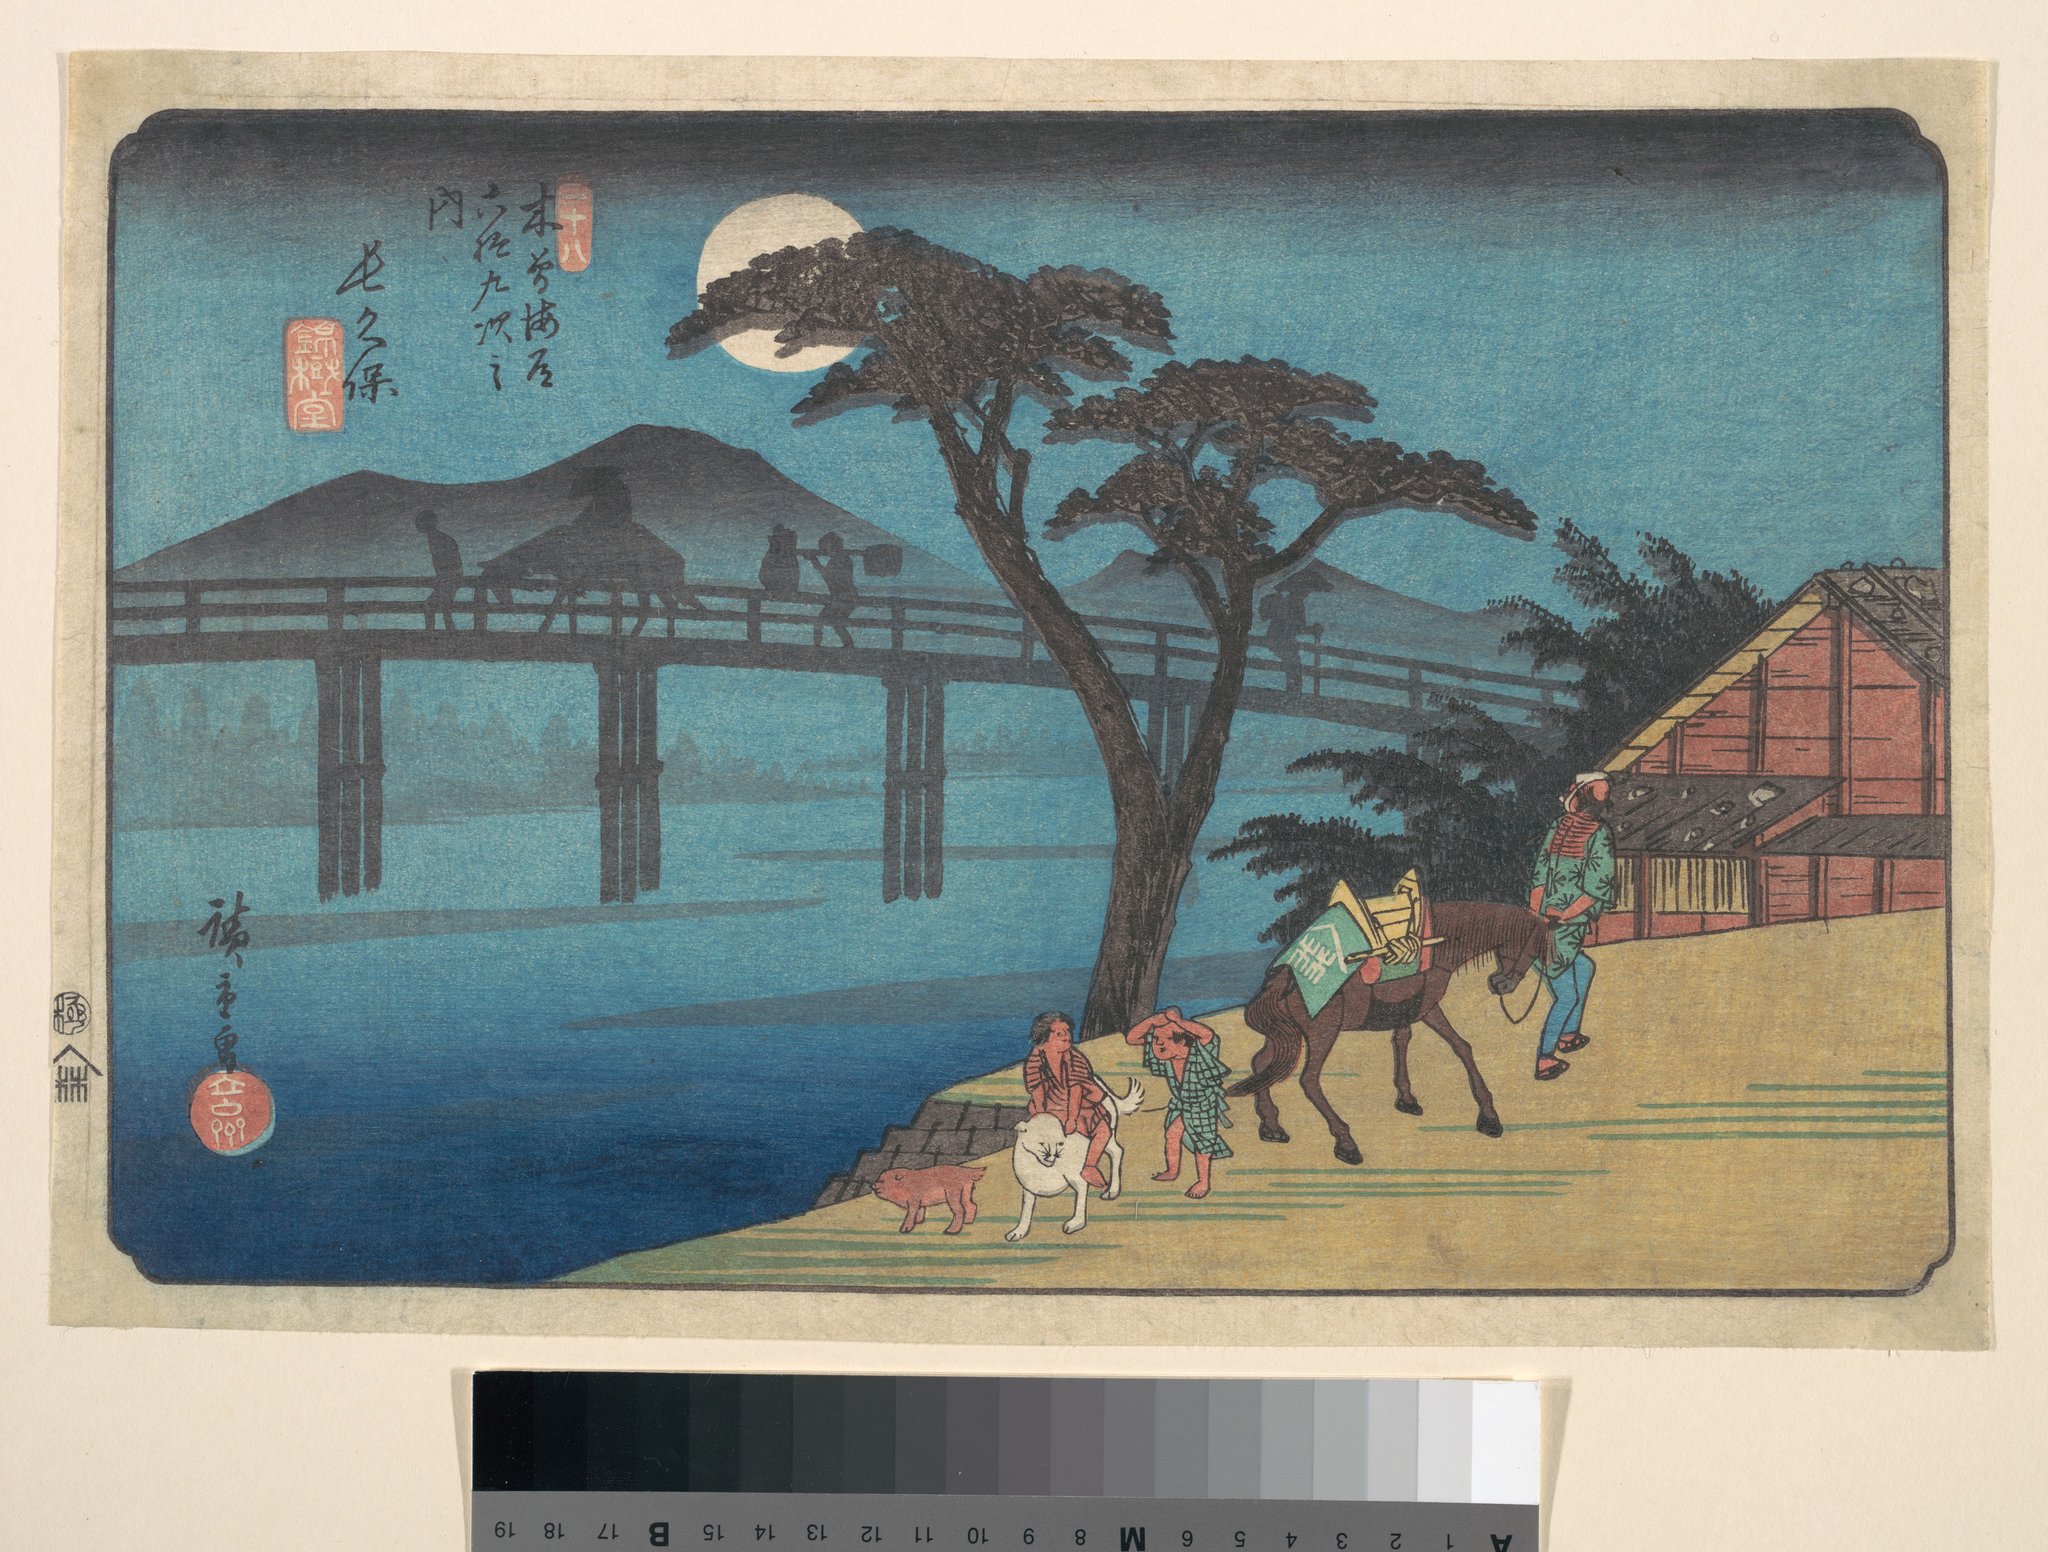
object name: print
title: Nagakubo Station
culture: japanese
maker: utagawa hiroshige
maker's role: artist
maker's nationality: japanese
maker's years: 1797-1858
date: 1836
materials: ink, paper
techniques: woodblock print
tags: bridges,men,horses,moon,trees